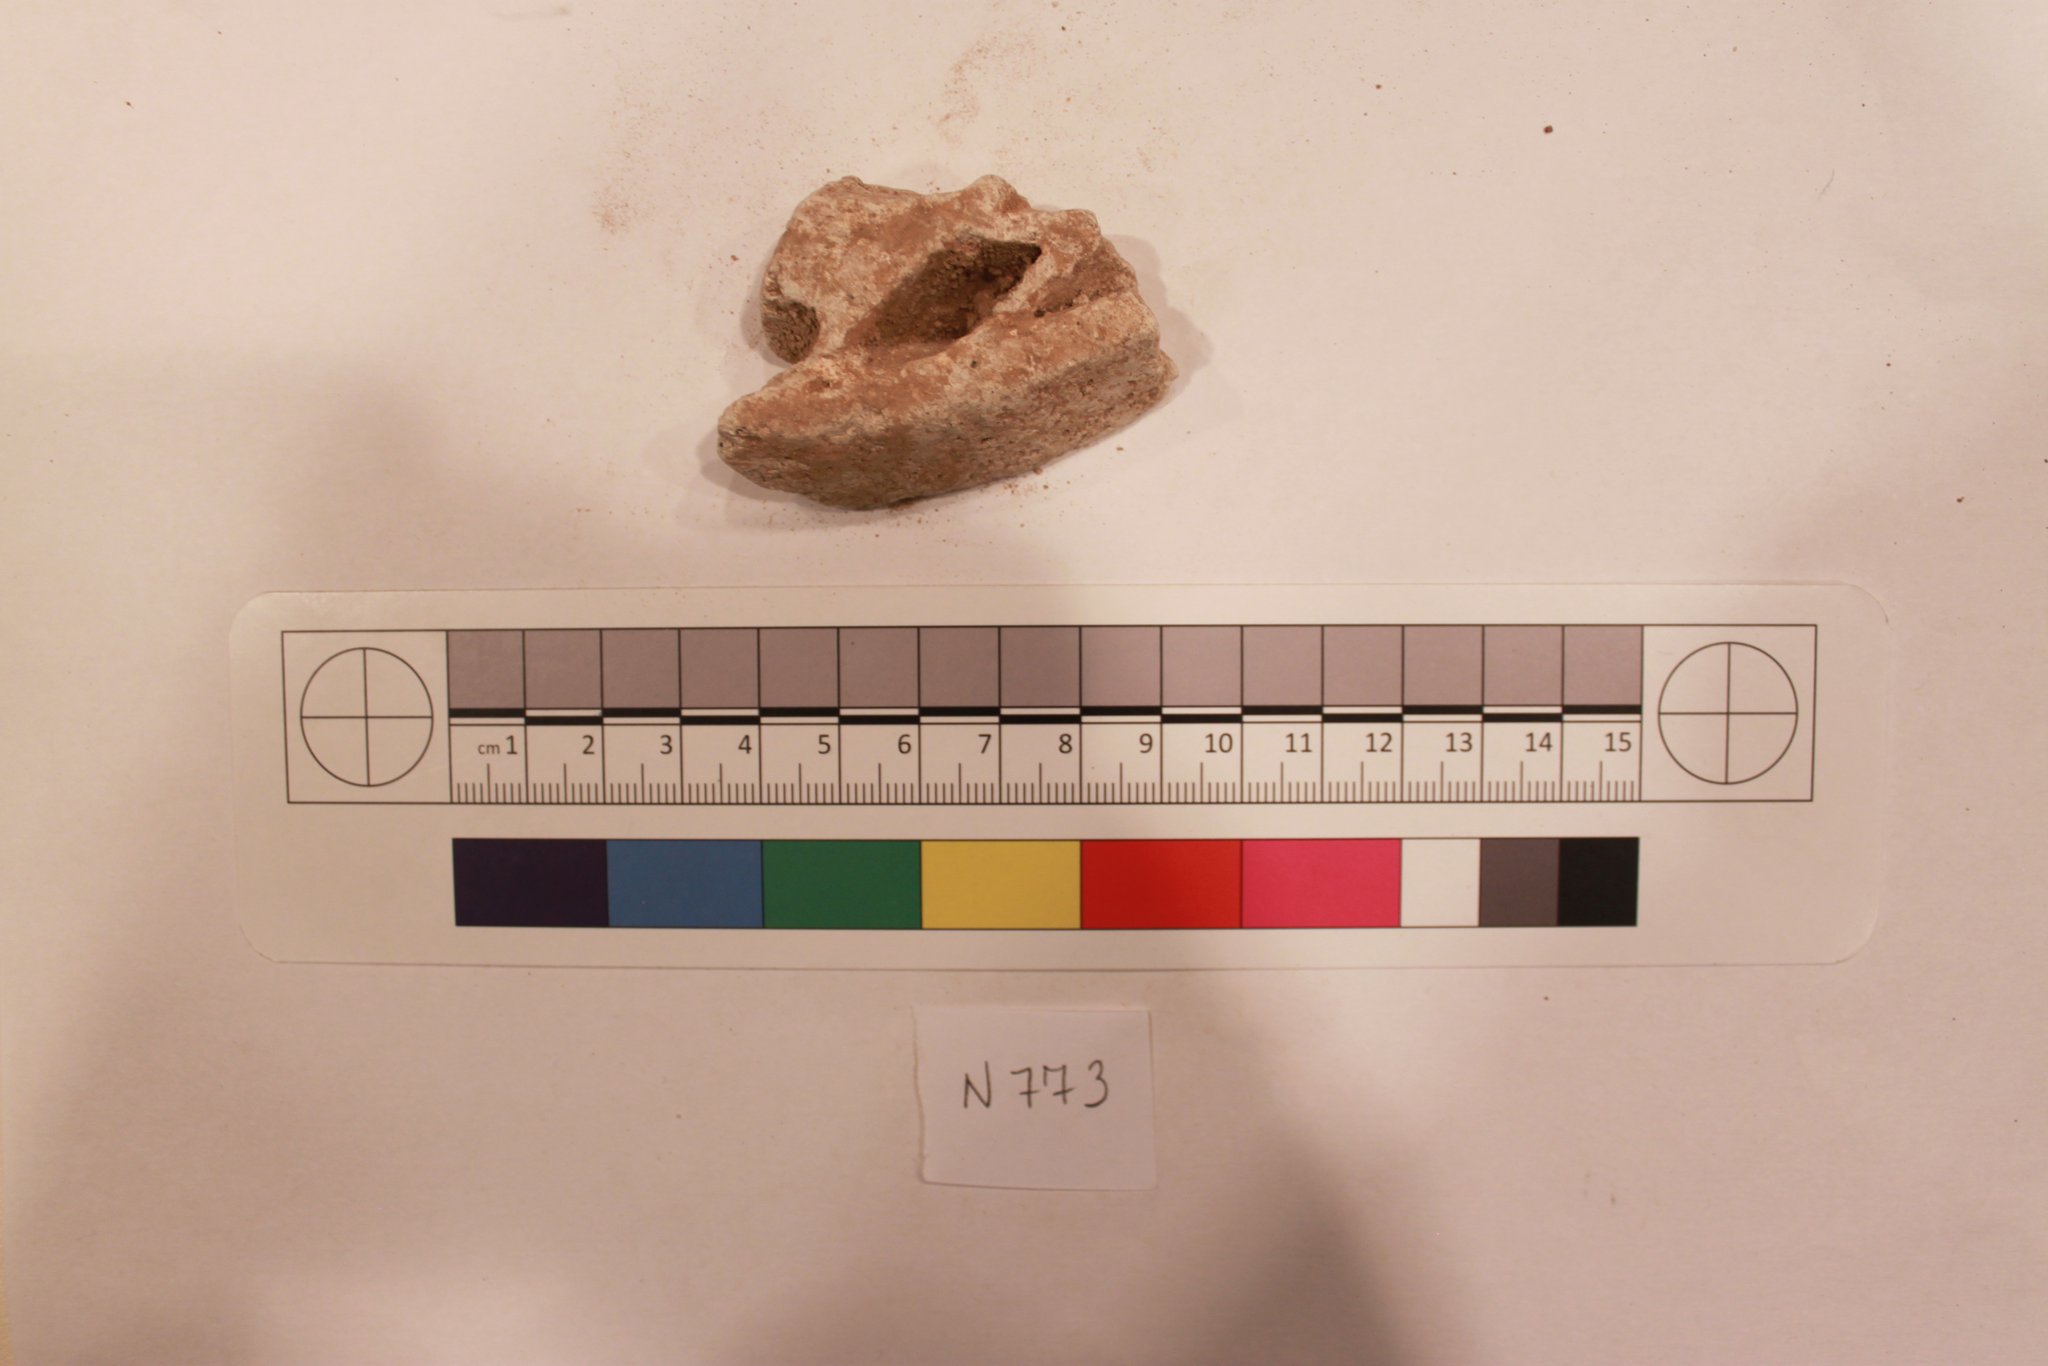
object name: fragment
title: Stucco Fragment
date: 701-1200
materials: plaster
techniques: carving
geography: iran